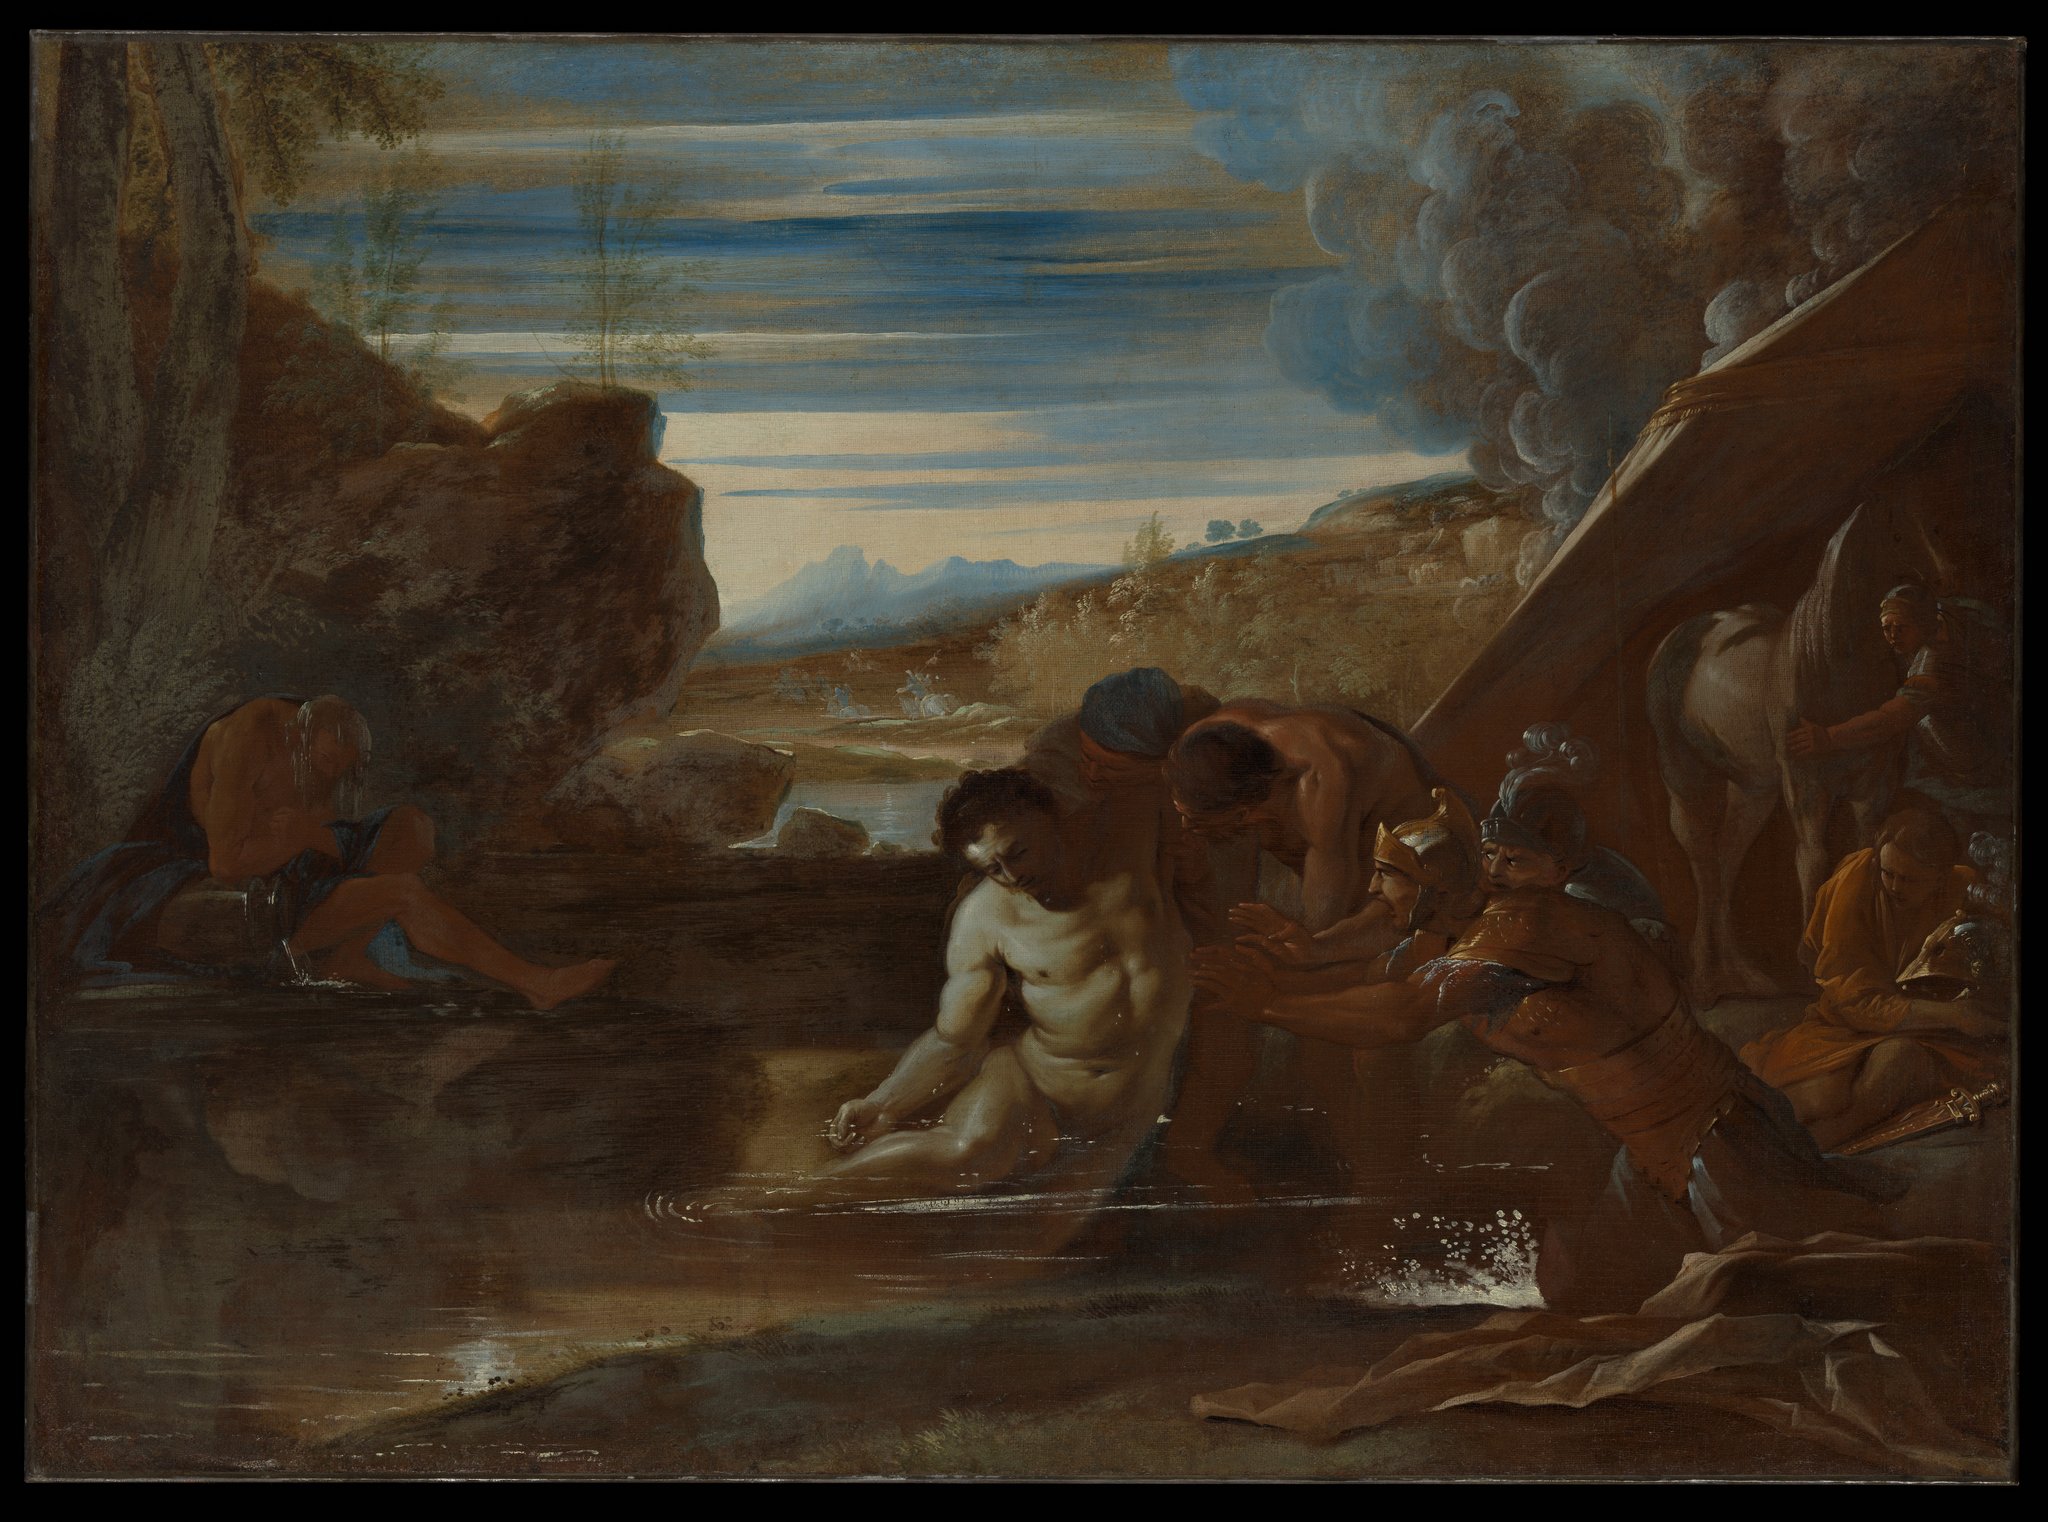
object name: painting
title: Alexander the Great Rescued from the River Cydnus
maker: pietro testa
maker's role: artist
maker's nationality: italian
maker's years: 1612-1650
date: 1650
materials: canvas, oil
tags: soldiers,alexander the great,male nudes,horses,rivers,bathing